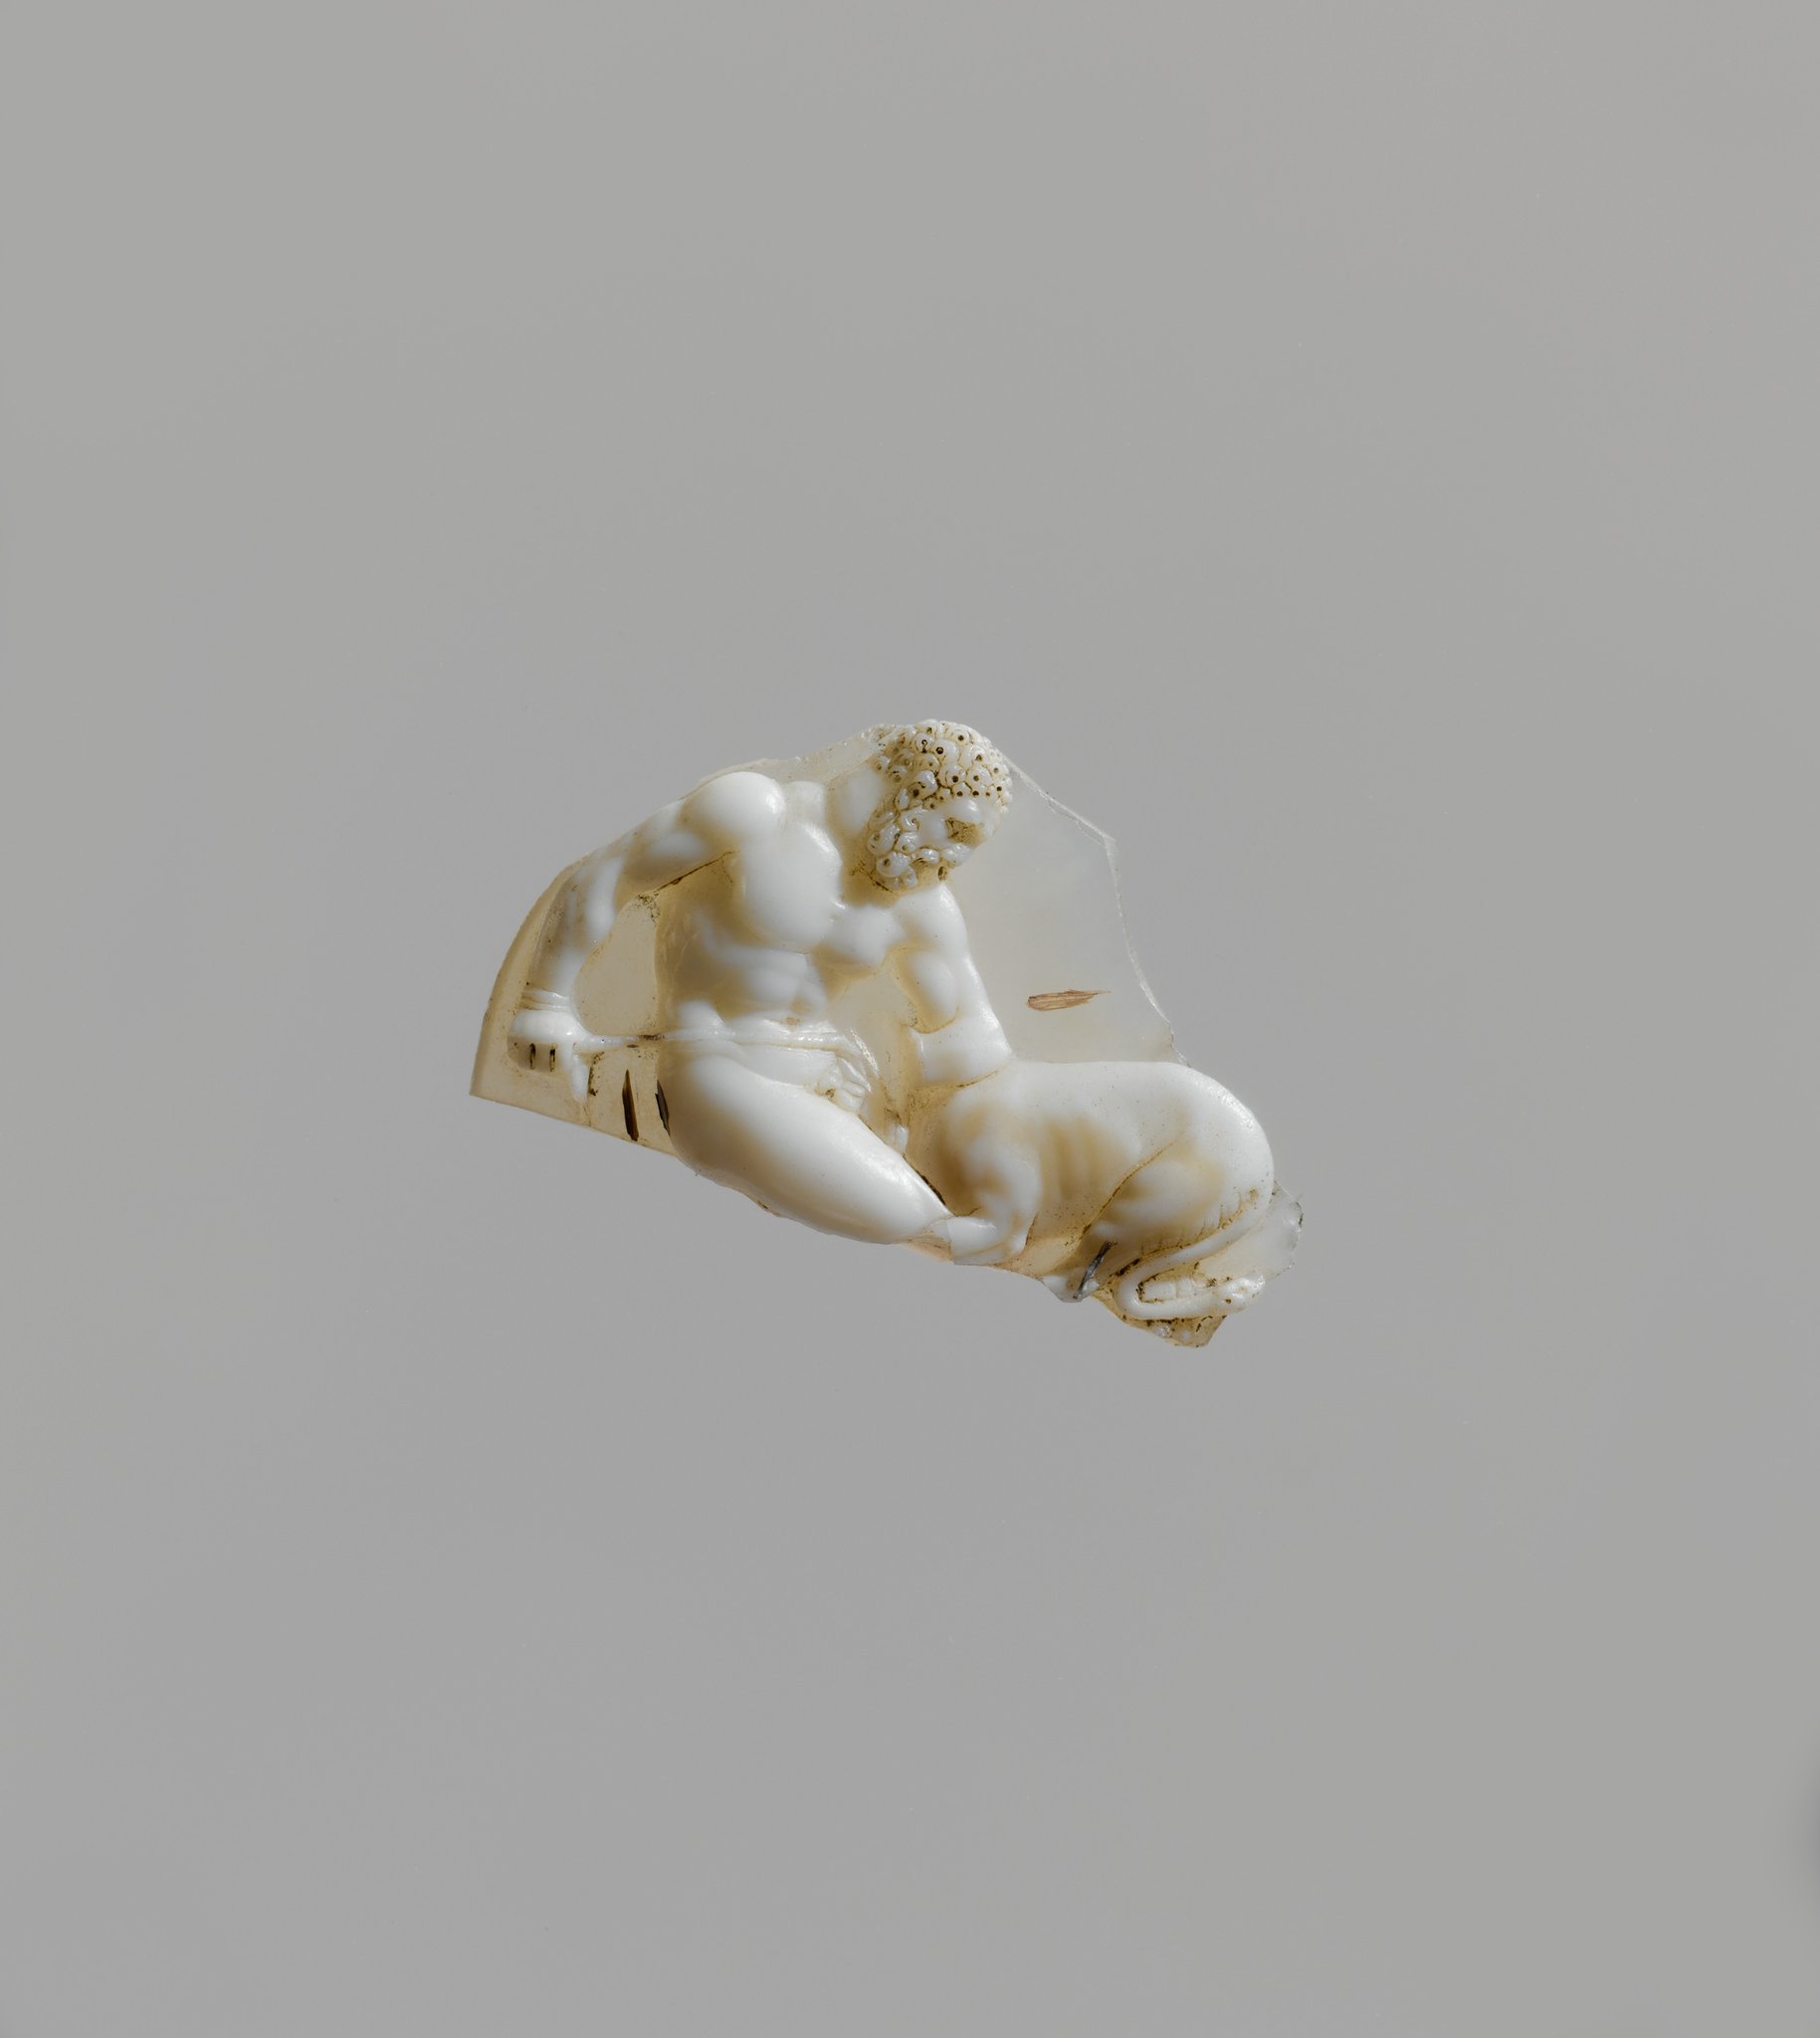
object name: cameo, fragment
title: Sardonyx cameo fragment with Hercules tying up Cerberus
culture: greek or roman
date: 100 BCE-100 CE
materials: gemstone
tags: male nudes,hercules